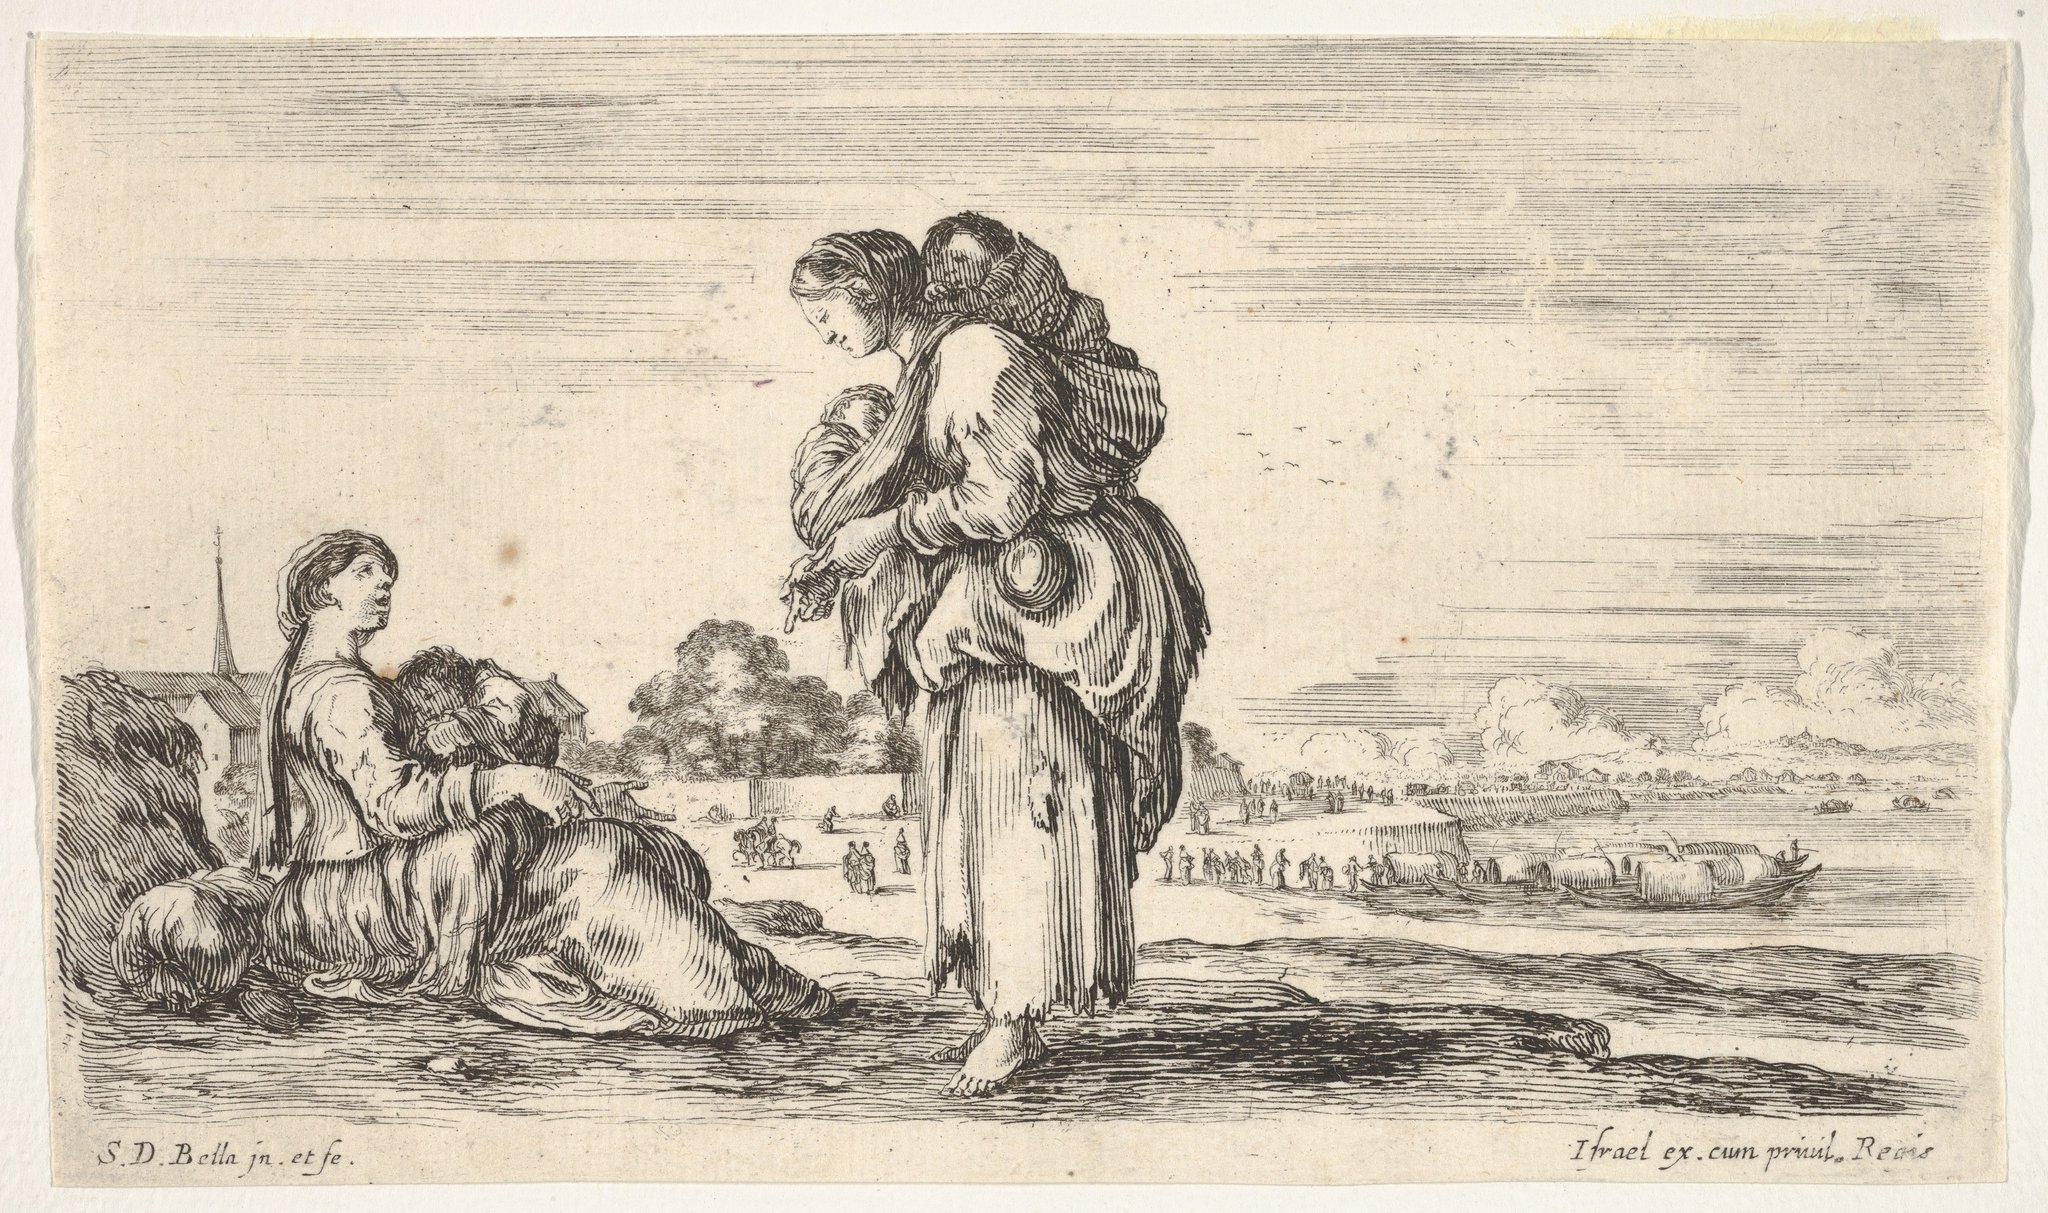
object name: print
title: A woman seated to left holding a child, facing right in profile, conversing with a standing woman in center, carrying one child on her back and another in her arms, a church to left in background and boats to right in background, from "Various figures and lands" (Diverse figure e paesi)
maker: stefano della bella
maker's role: artist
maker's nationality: italian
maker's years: 1610-1664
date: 1649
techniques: etching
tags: infants,women,boats